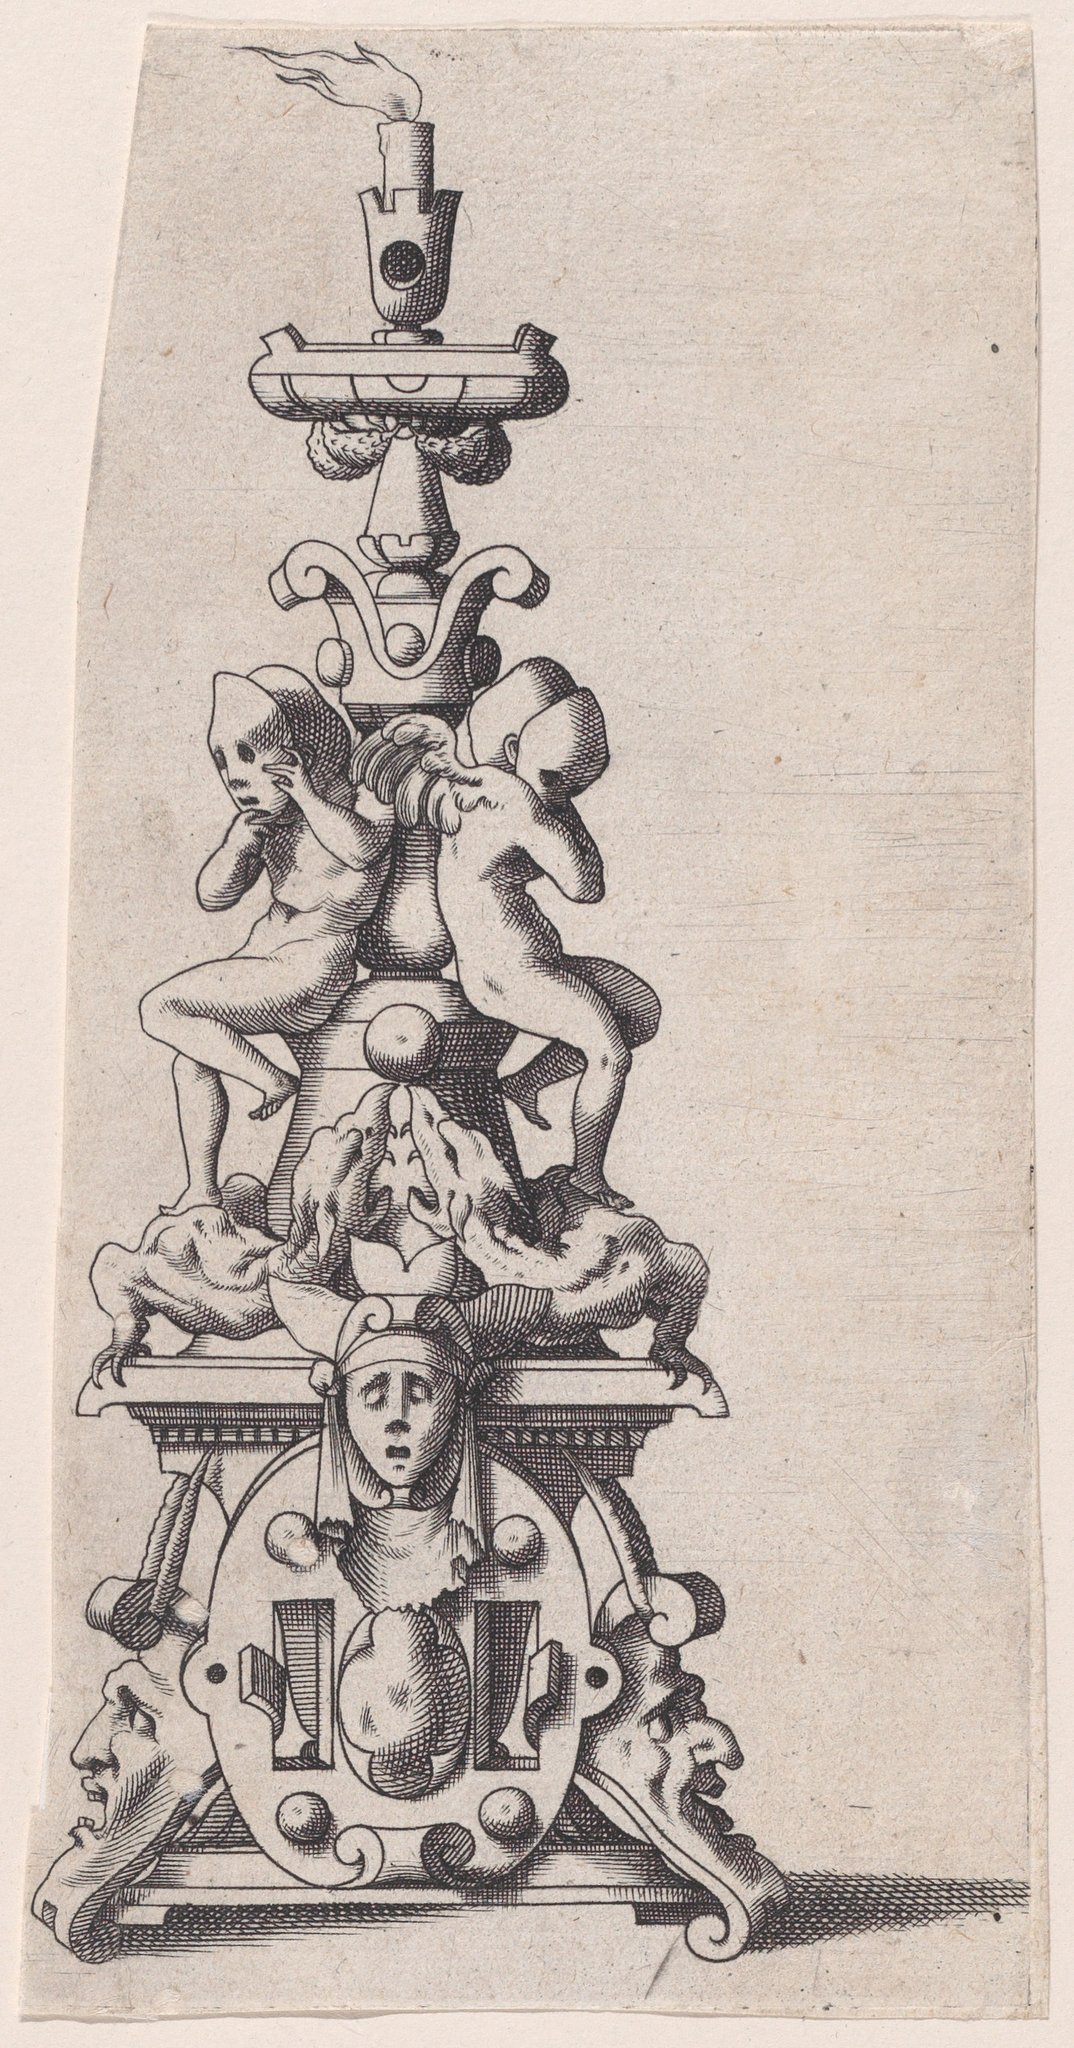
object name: print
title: Candlestick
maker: rené boyvin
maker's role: artist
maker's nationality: french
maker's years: 1525-1598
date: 1525-1600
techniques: engraving